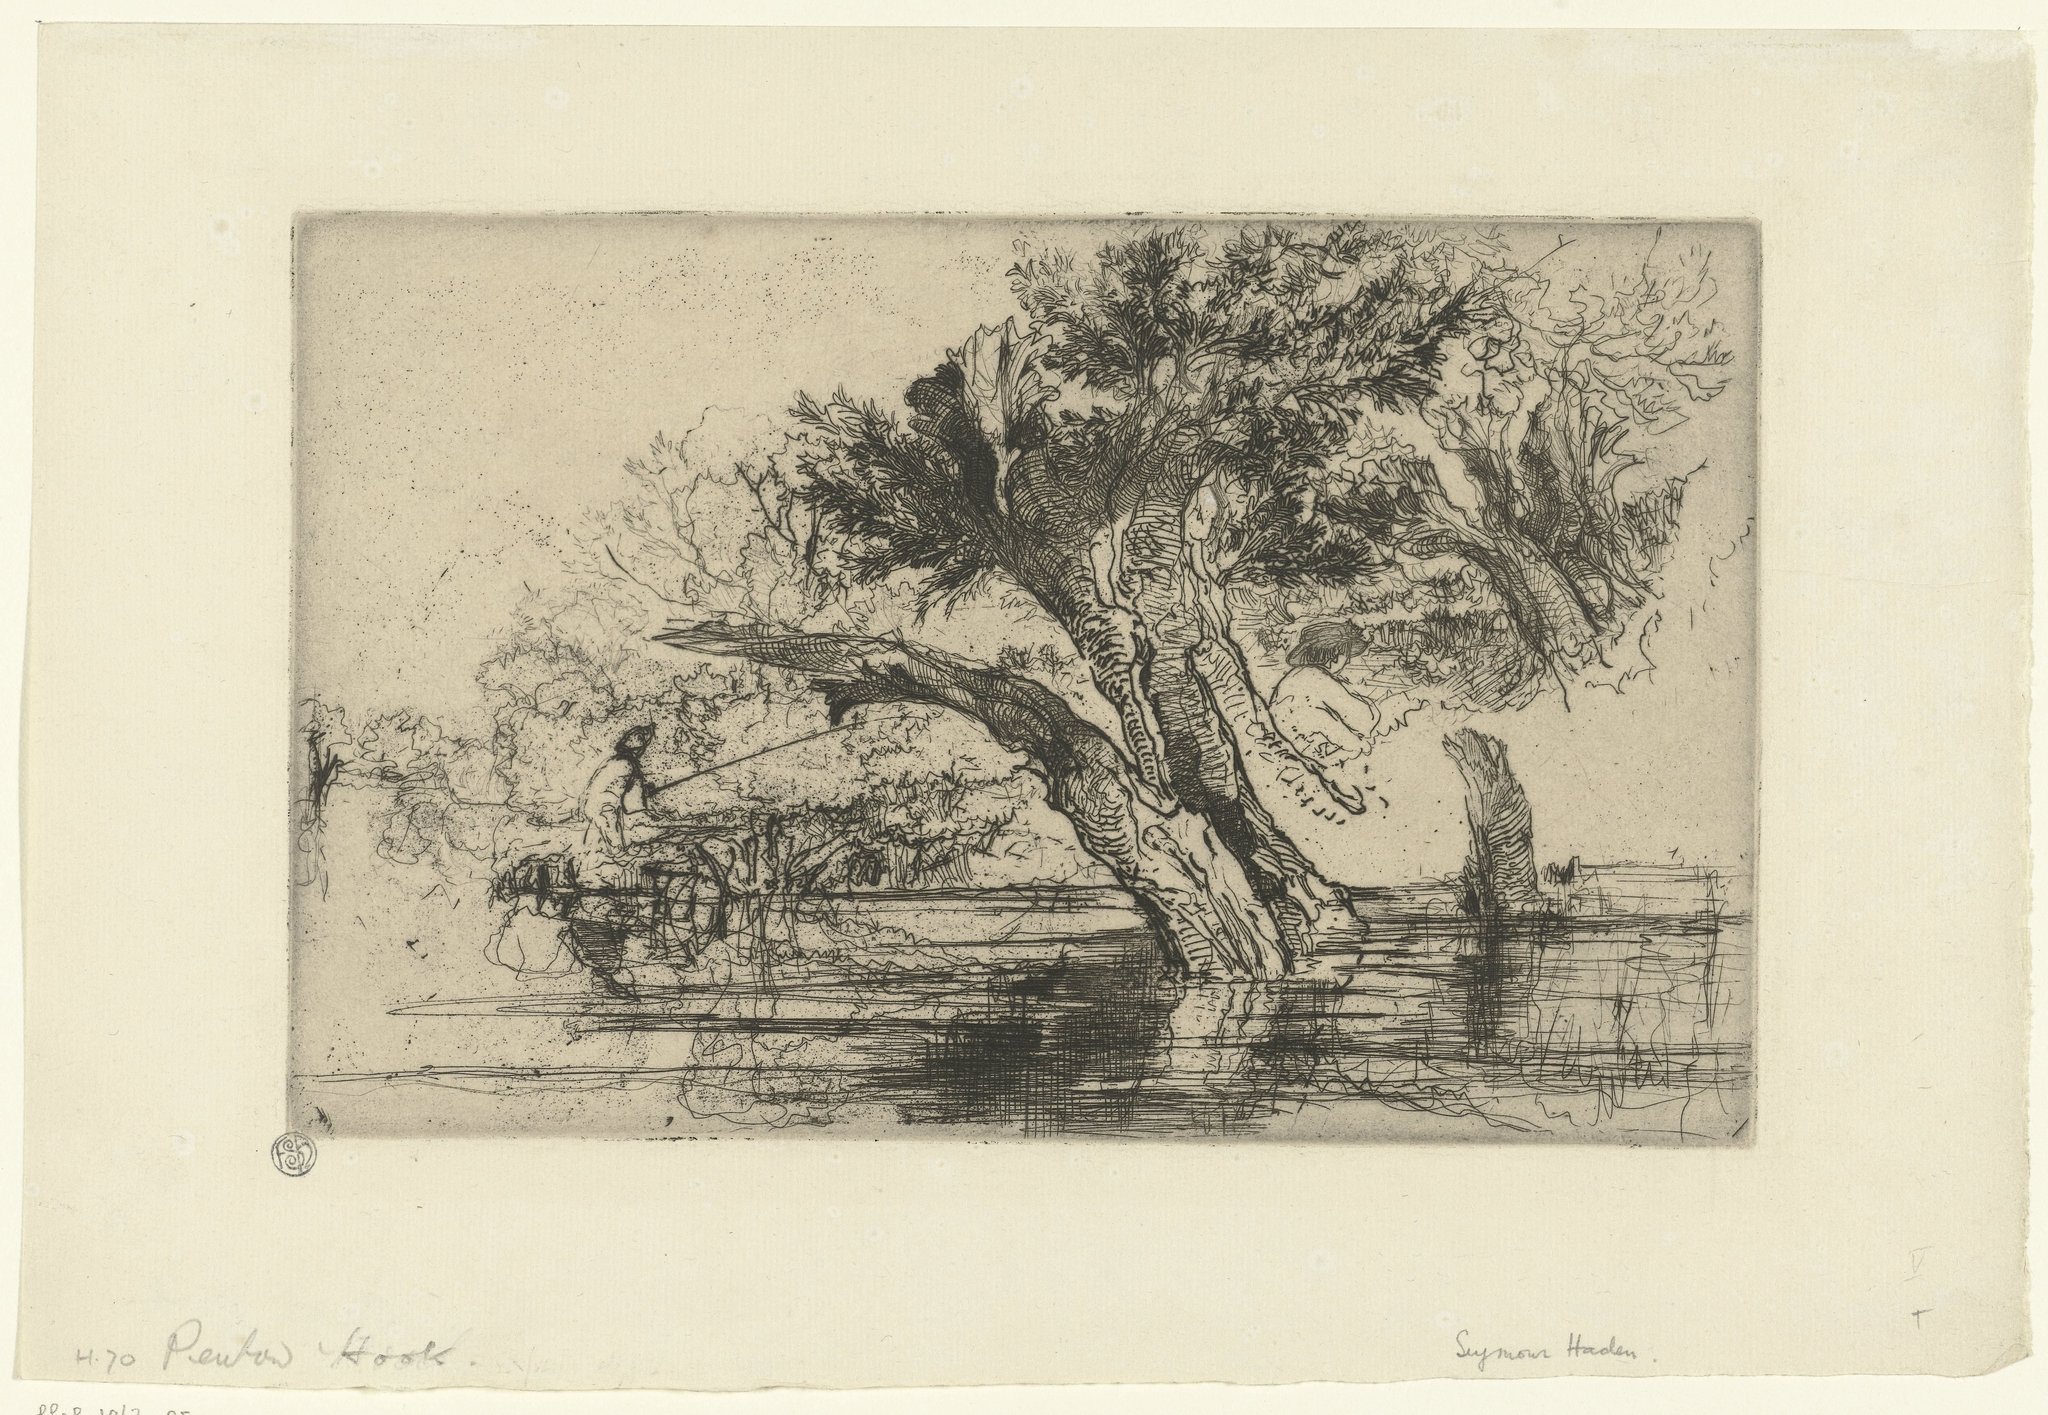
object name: print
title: Penton Hook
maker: francis seymour-haden (sir)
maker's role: print maker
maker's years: 1818-1910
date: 1864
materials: paper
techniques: drypoint, etching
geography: england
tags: river, thames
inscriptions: collector's mark: Lugt 1048, collector's mark: Lugt 2760, collector's mark: Lugt 2228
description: Een oude boom staand in het water van de rivier. Op de begroeide oever twee zittende figuren, één met een hengel.